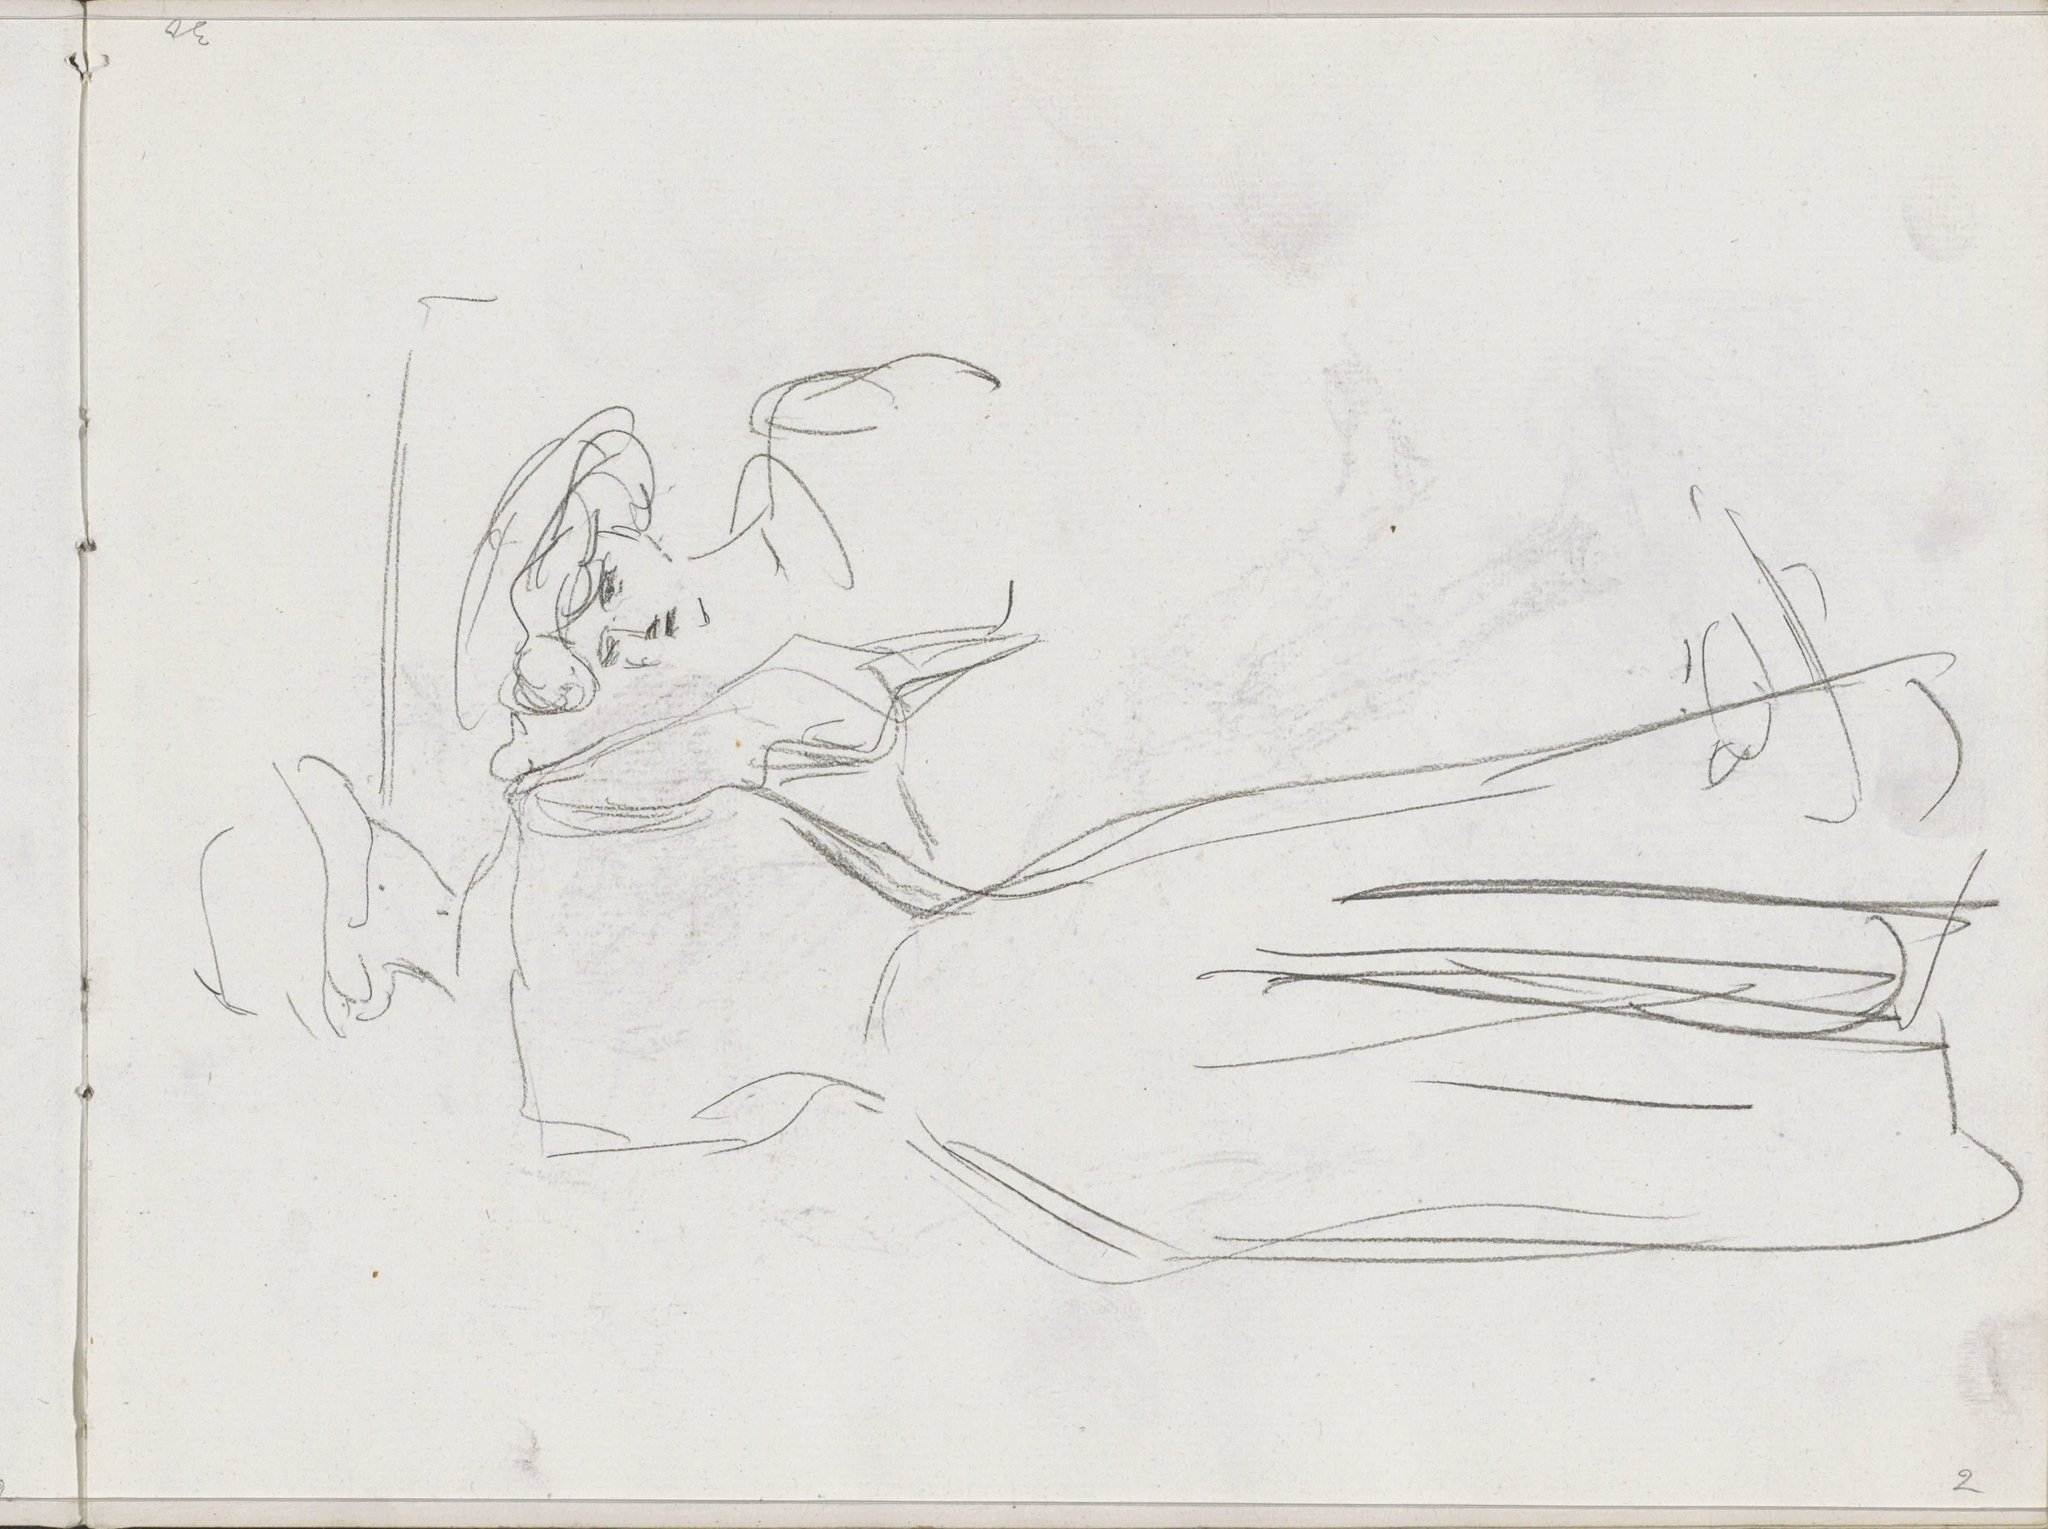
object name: sketchbook leaf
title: Twee vrouwen tegenover elkaar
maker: isaac israels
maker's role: draughtsman, painter, print maker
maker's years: 1865-1934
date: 1875-1934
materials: chalk, paper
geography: the hague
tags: adult woman (+ standing), reflection (in a mirror) - aa - (for) women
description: Of een vrouw die zichzelf in een spiegel bekijkt. Blad 2 recto uit schetsboek XXII met 30 bladen.